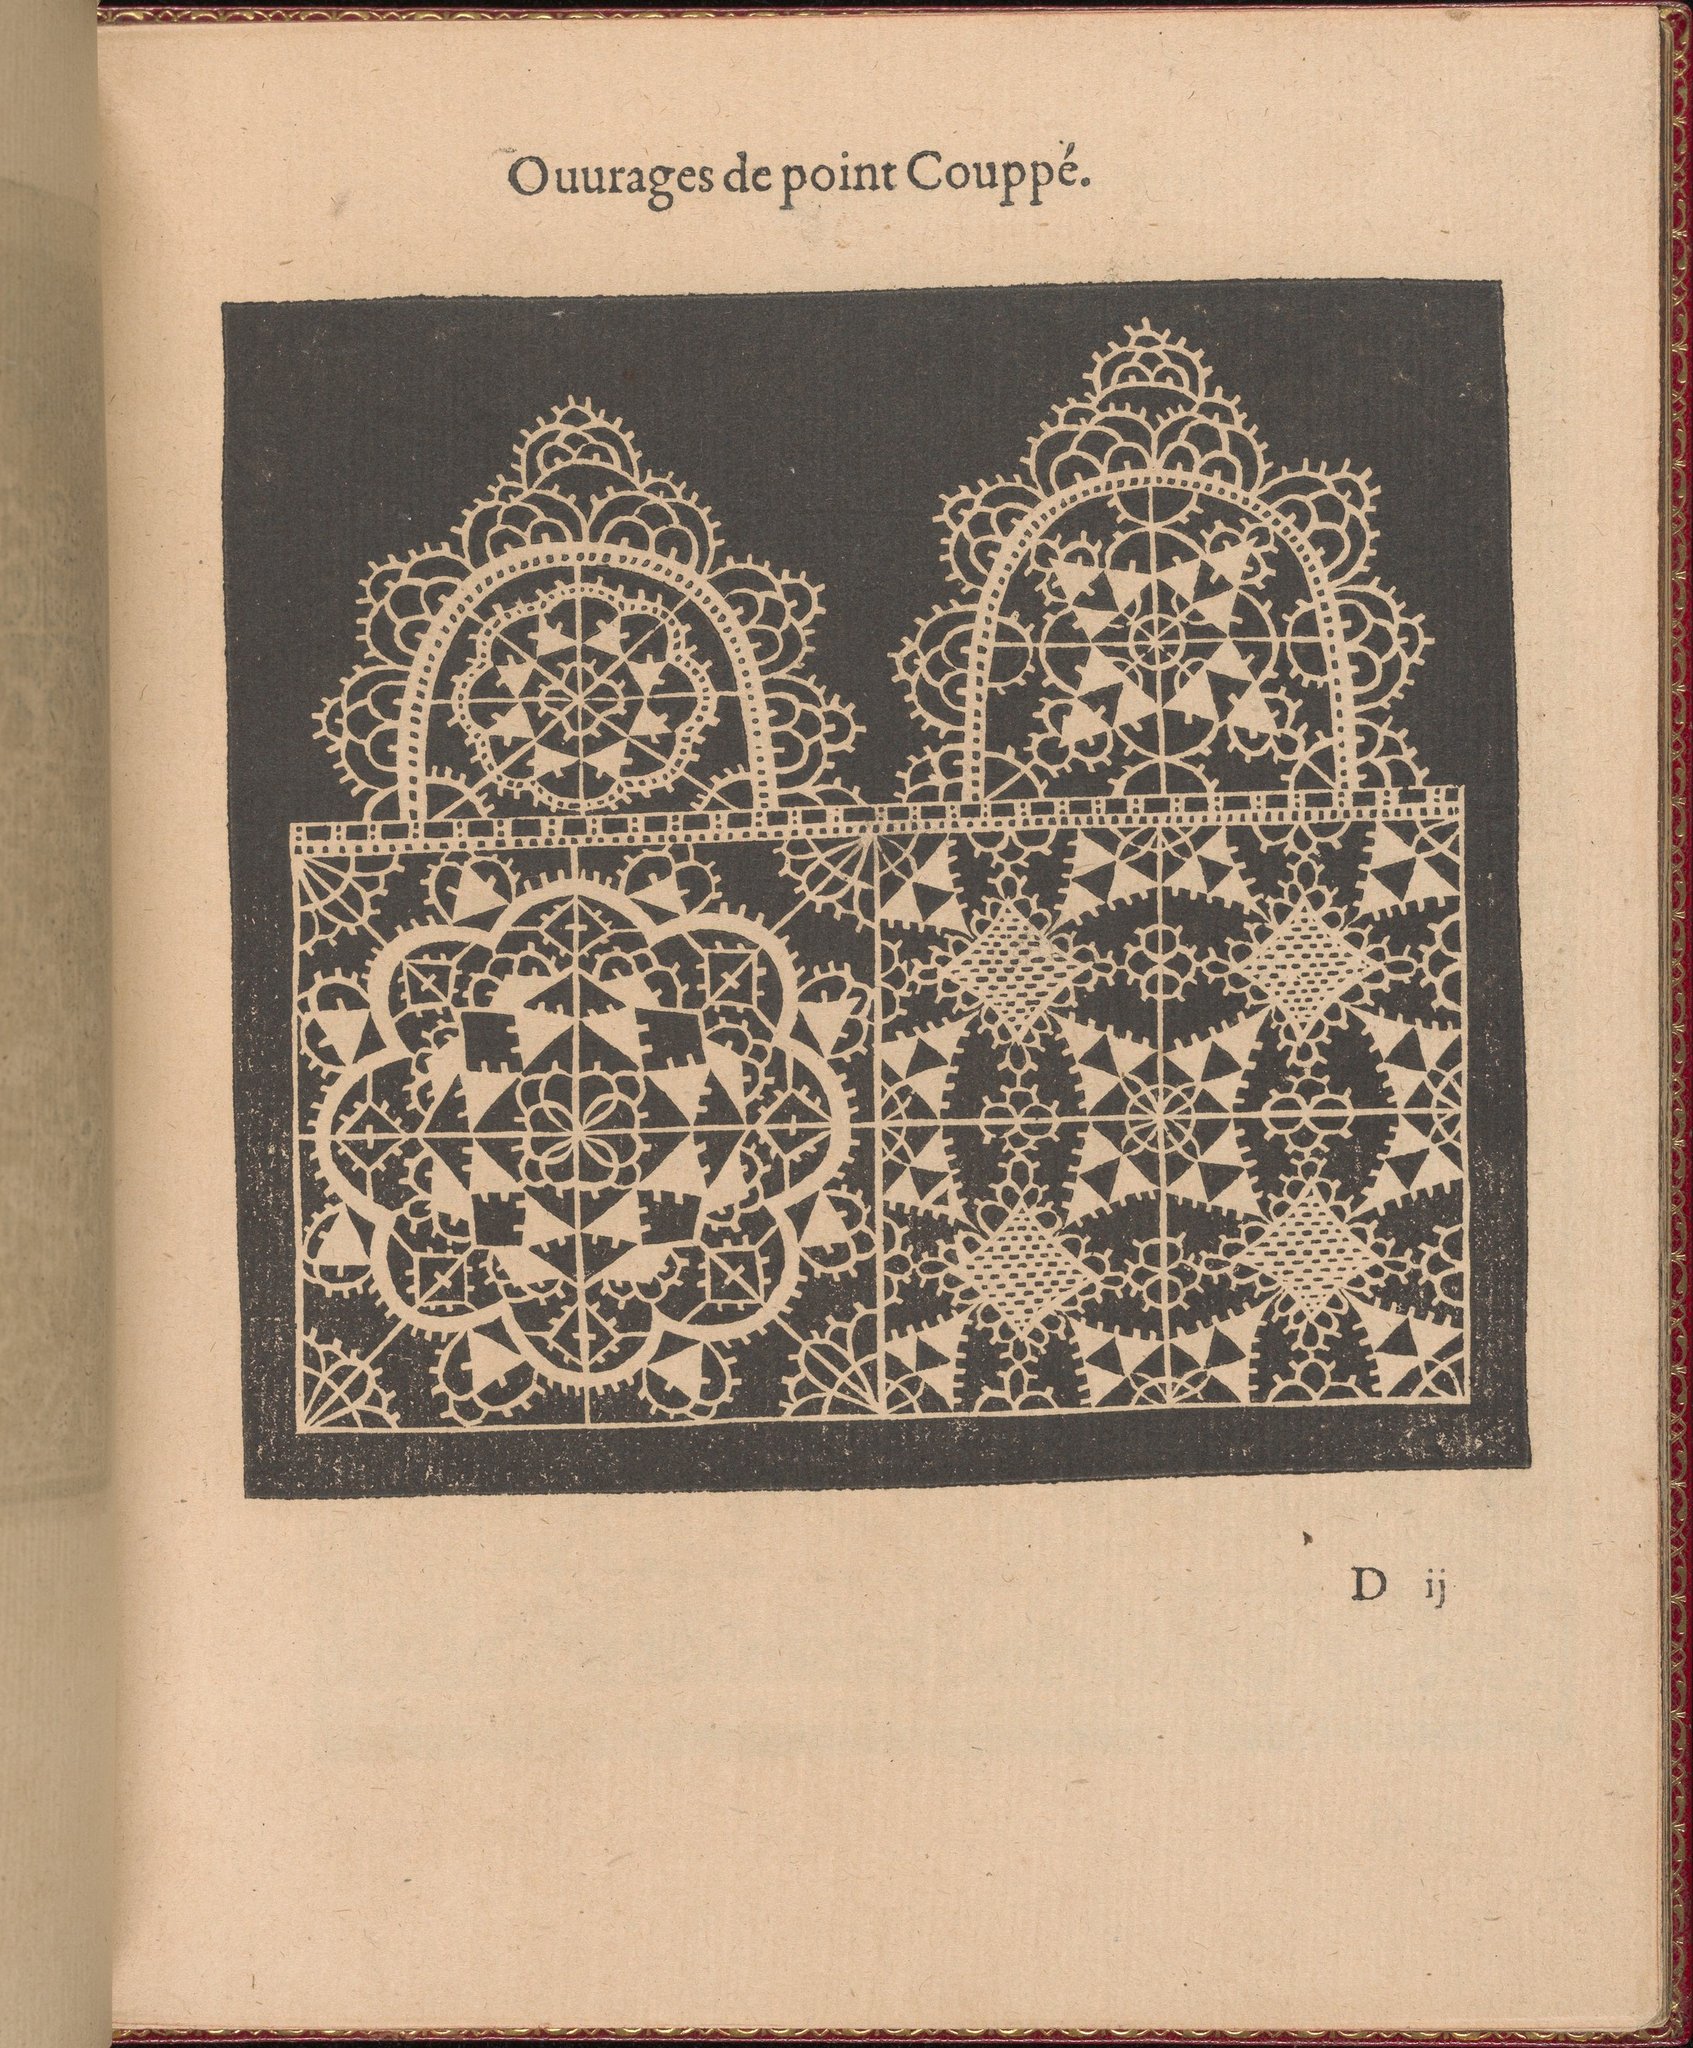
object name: book print ornament architecture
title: Les Singuliers et Nouveaux Portraicts... page 14 (recto)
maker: federico de vinciolo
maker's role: designer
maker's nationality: italian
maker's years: 1582-1599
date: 1588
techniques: woodcut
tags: ornament